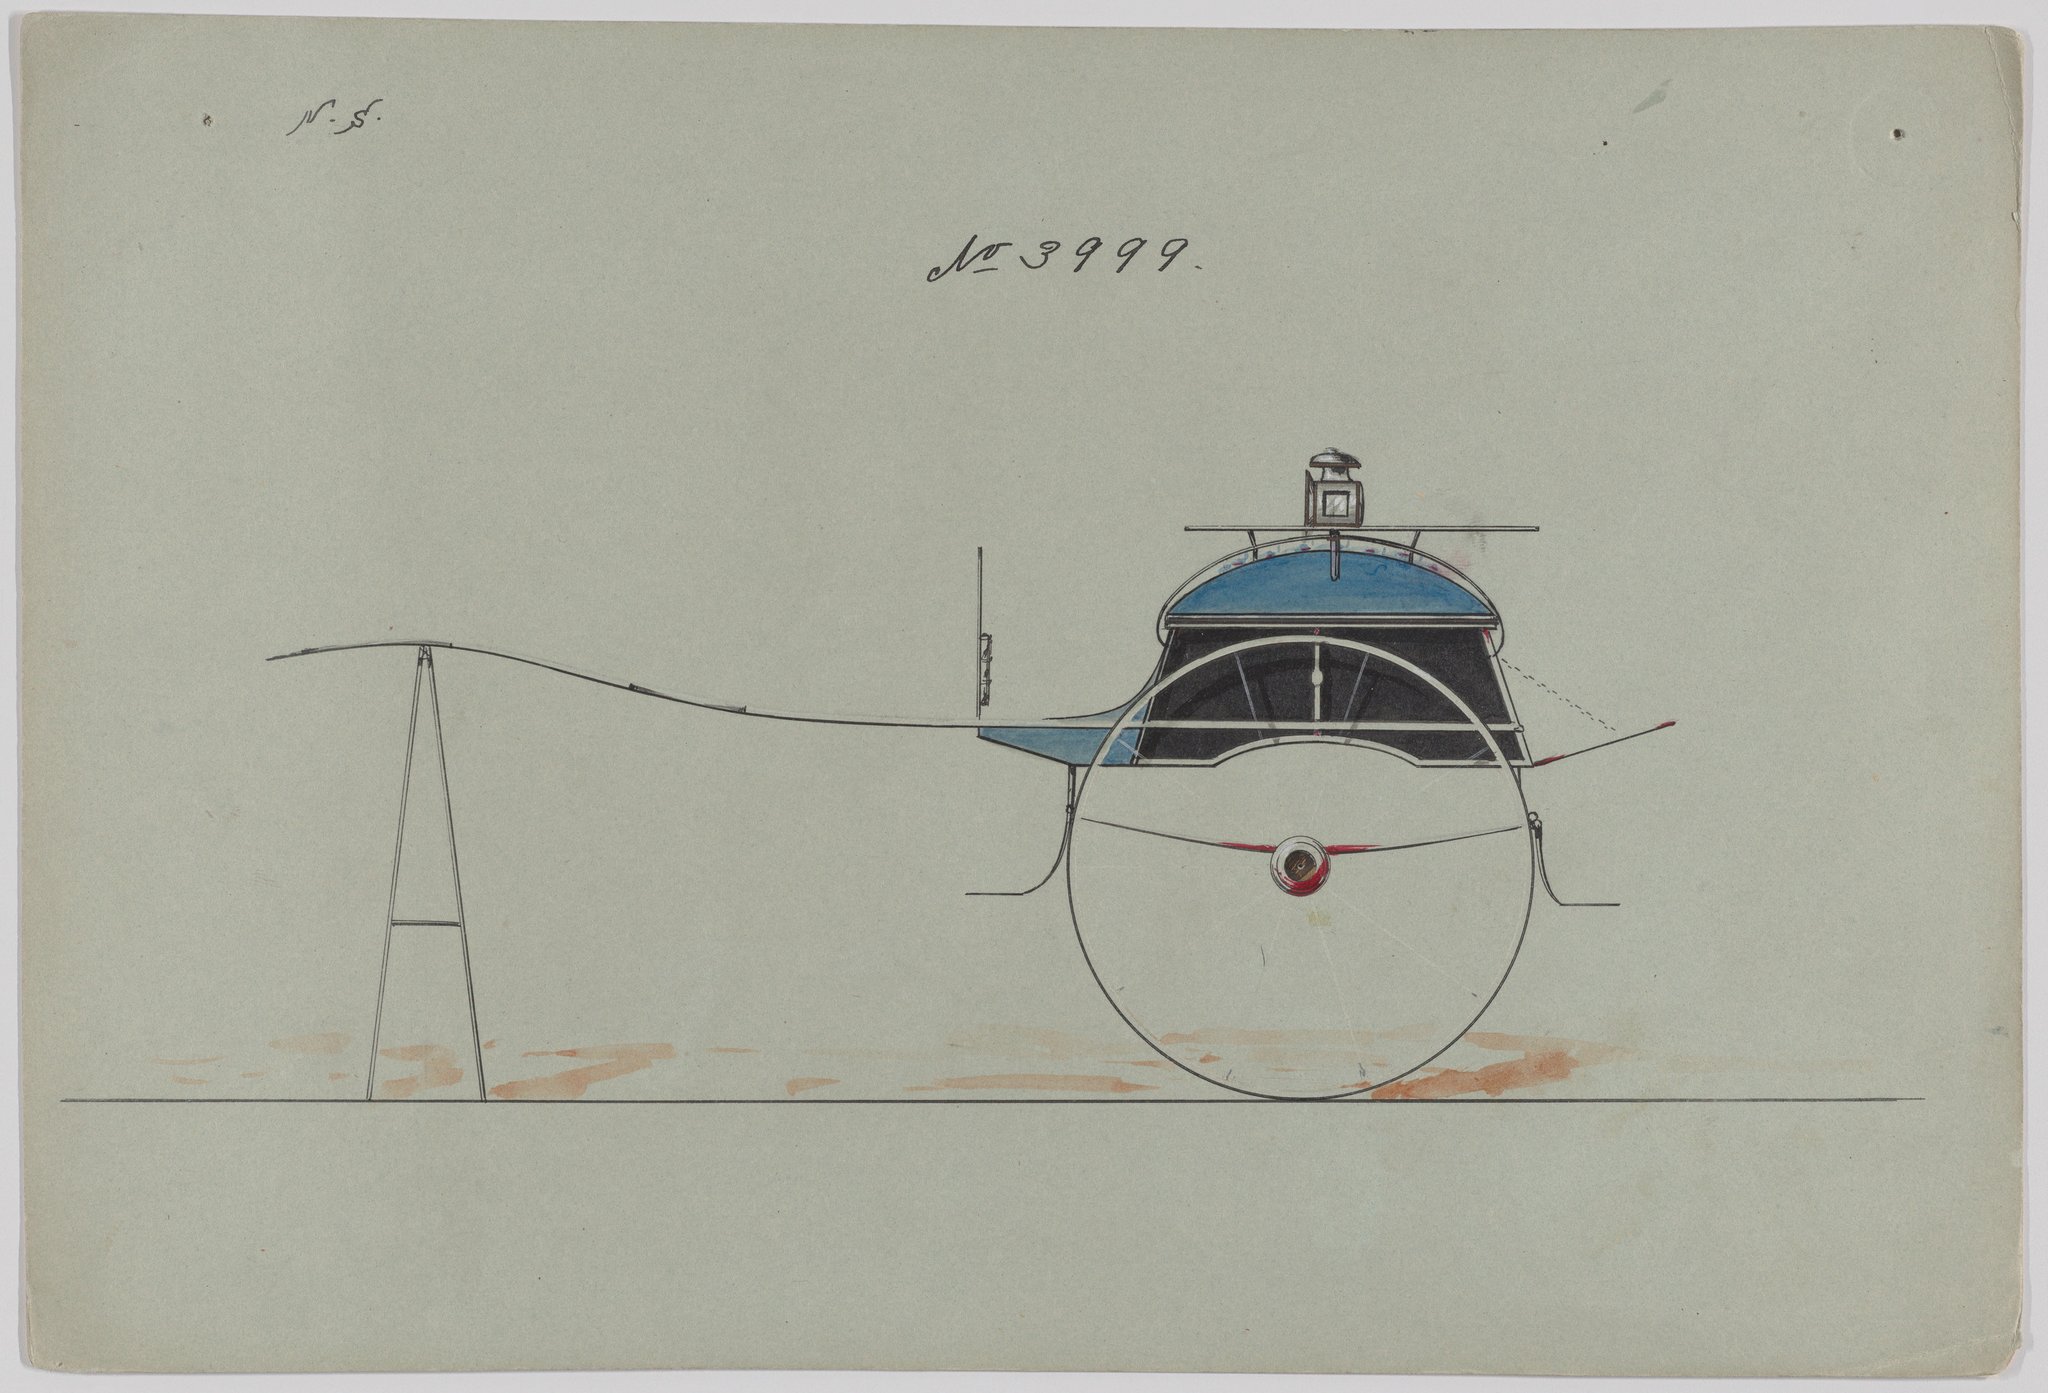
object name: drawing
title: Design for Dog Cart or 2 Wheeler, no. 3999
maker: brewster & co.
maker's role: manufacturer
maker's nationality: american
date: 1887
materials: gouache, ink, watercolor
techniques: pen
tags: carriages